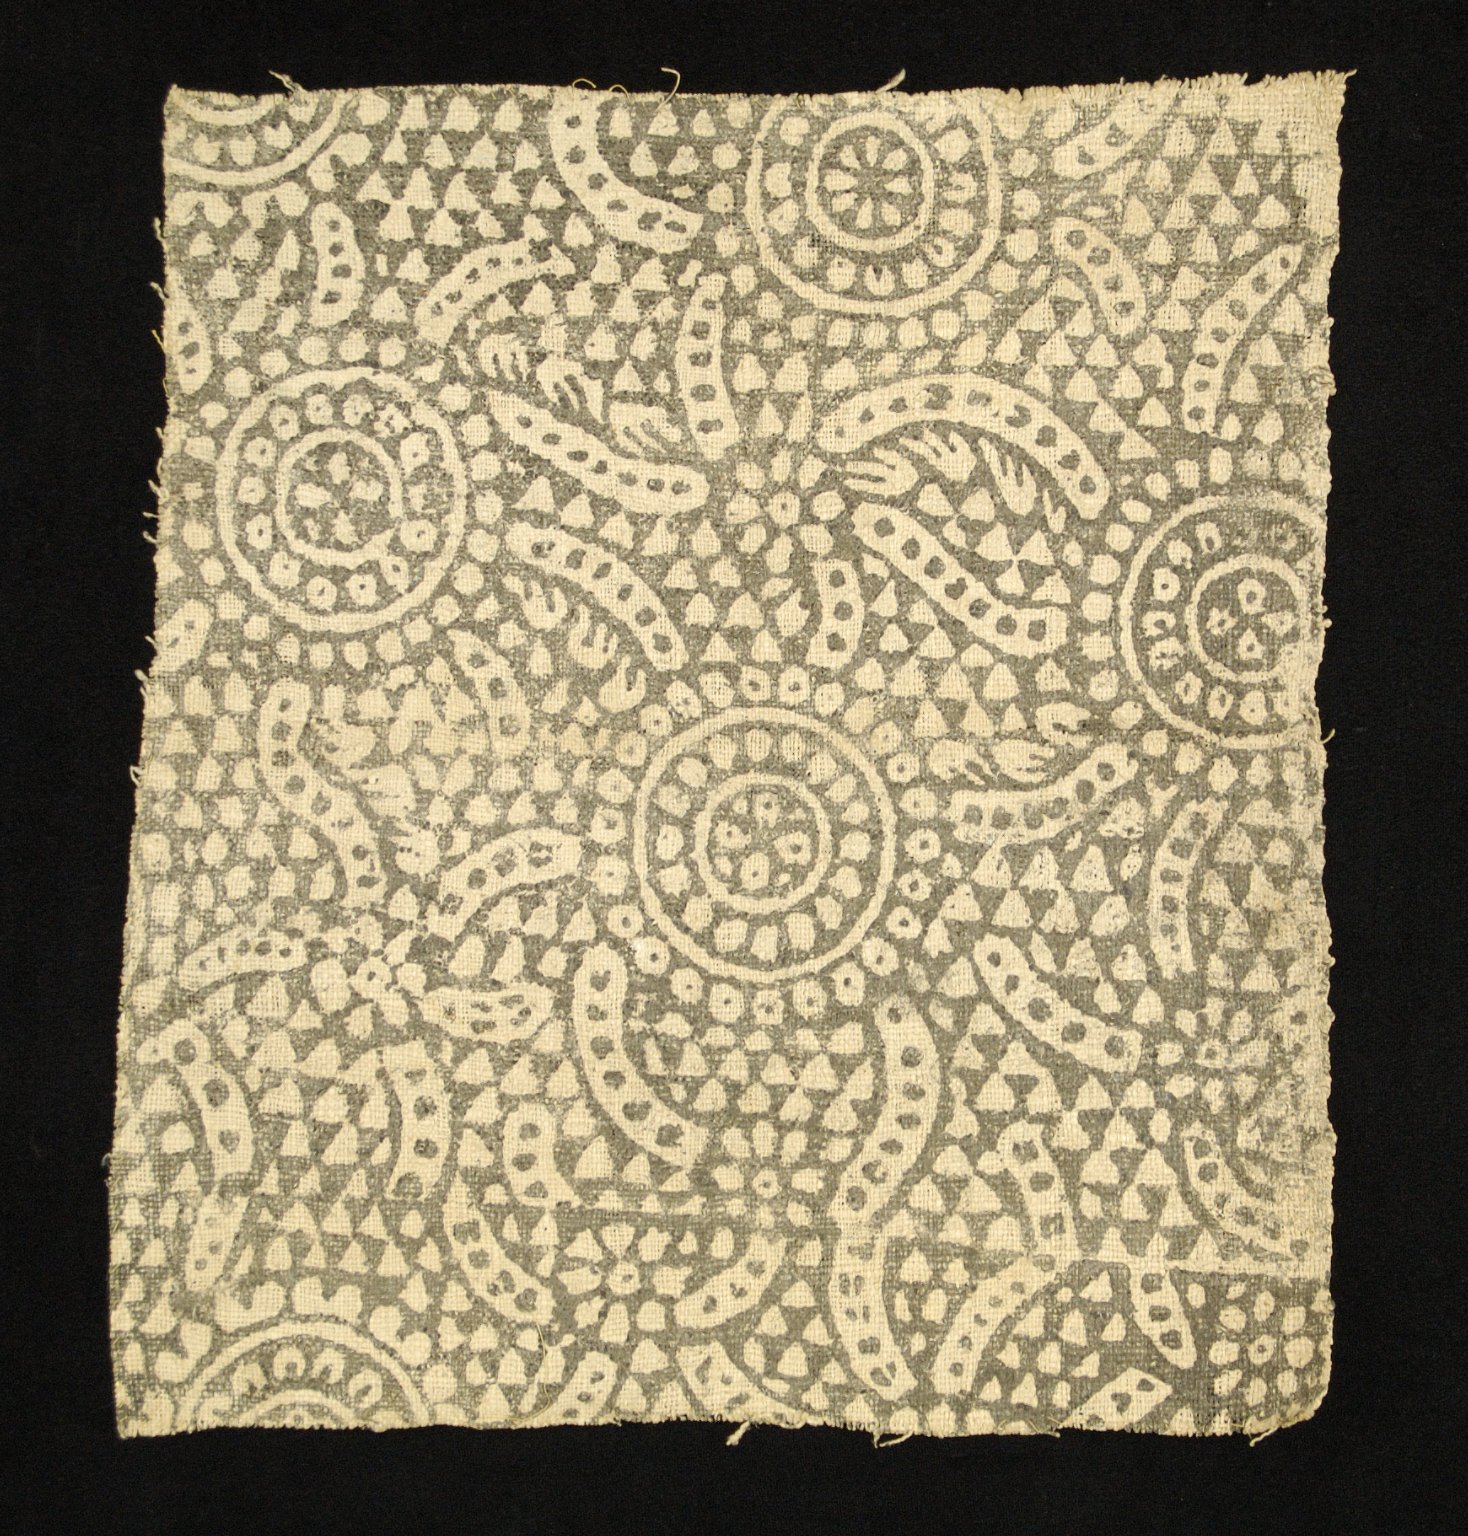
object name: textile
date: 1700-1899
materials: linen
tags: flowers